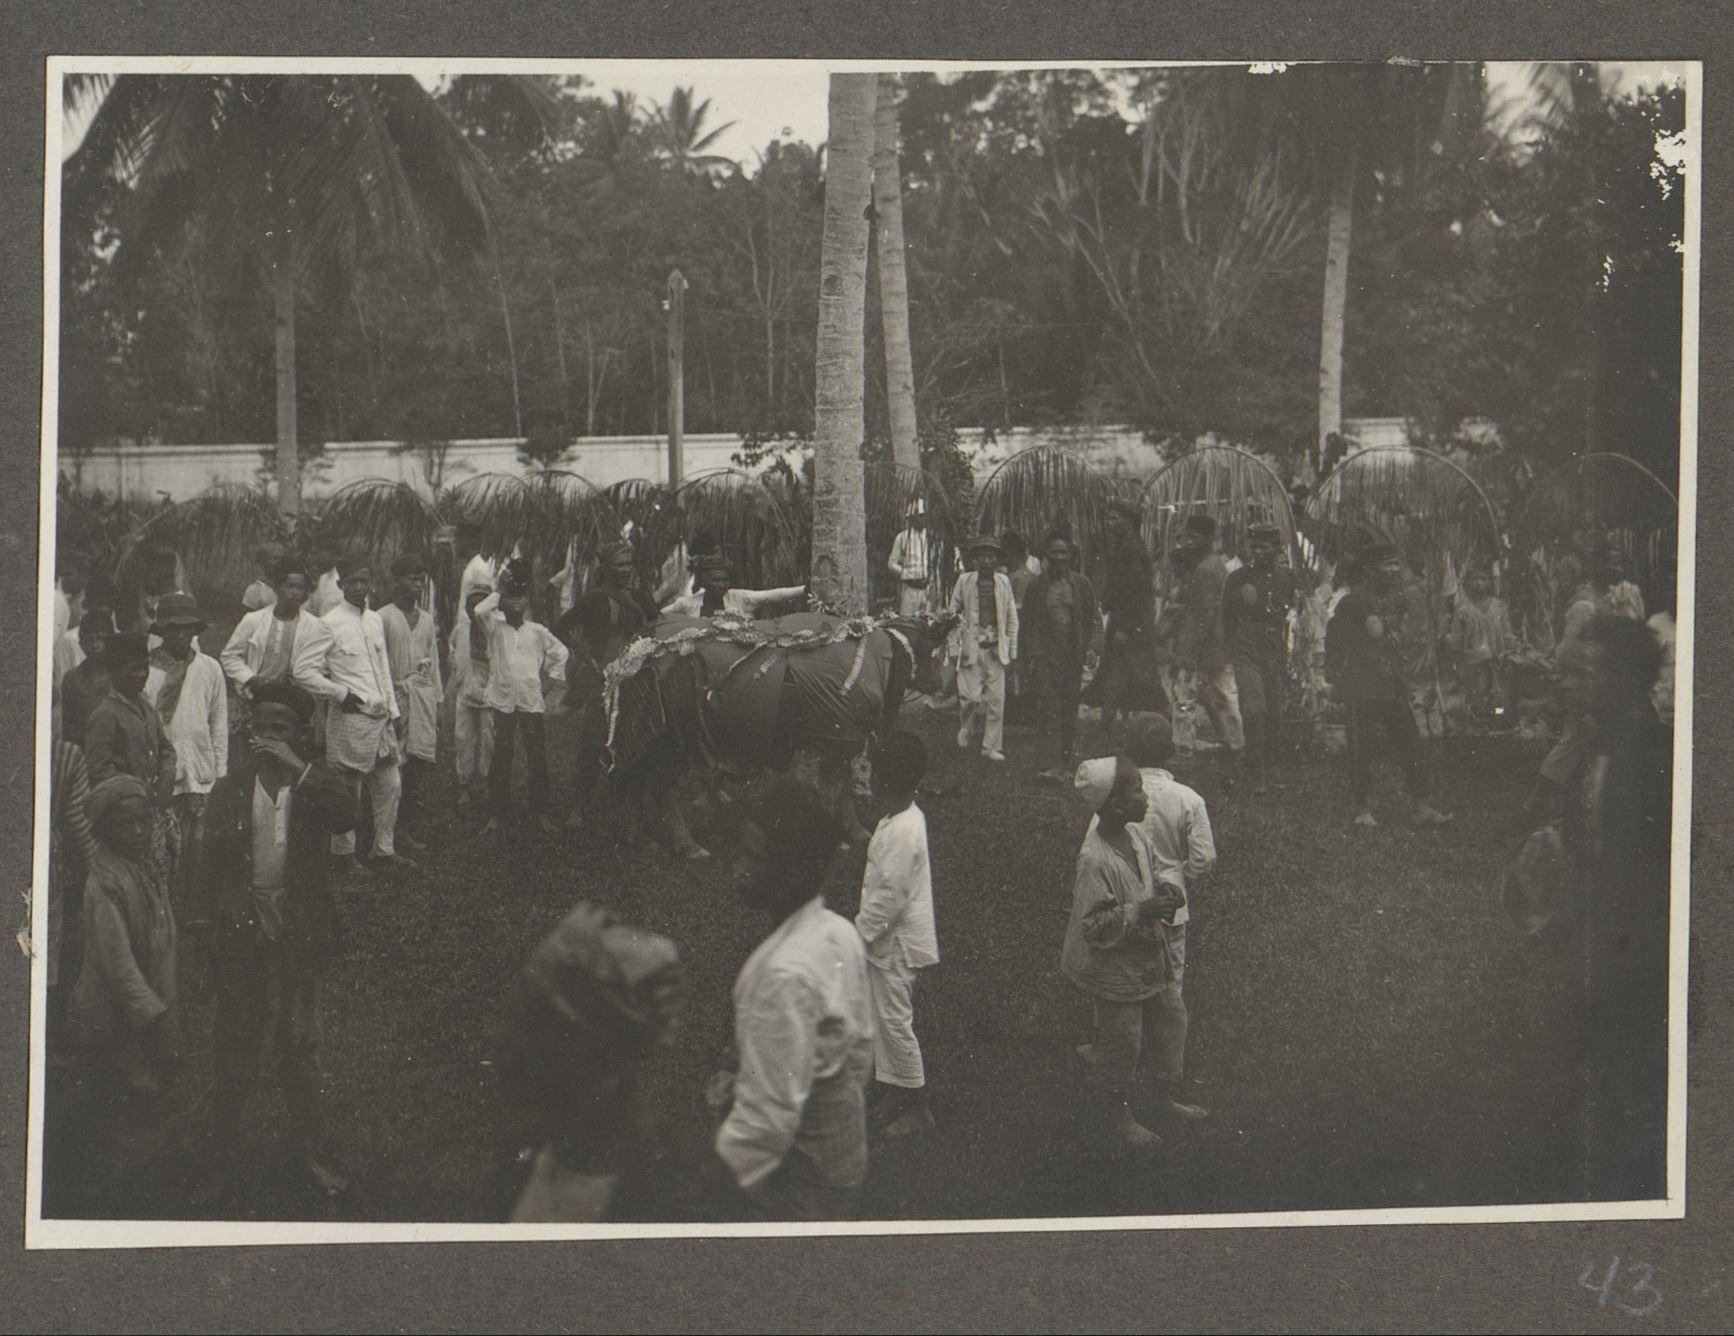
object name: album leaf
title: Versierde koe met omstanders bij het paleis van de Sultan van Langkat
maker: Anonymous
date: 1919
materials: photographic support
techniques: gelatin silver print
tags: trees, cow, historical persons, sumatra